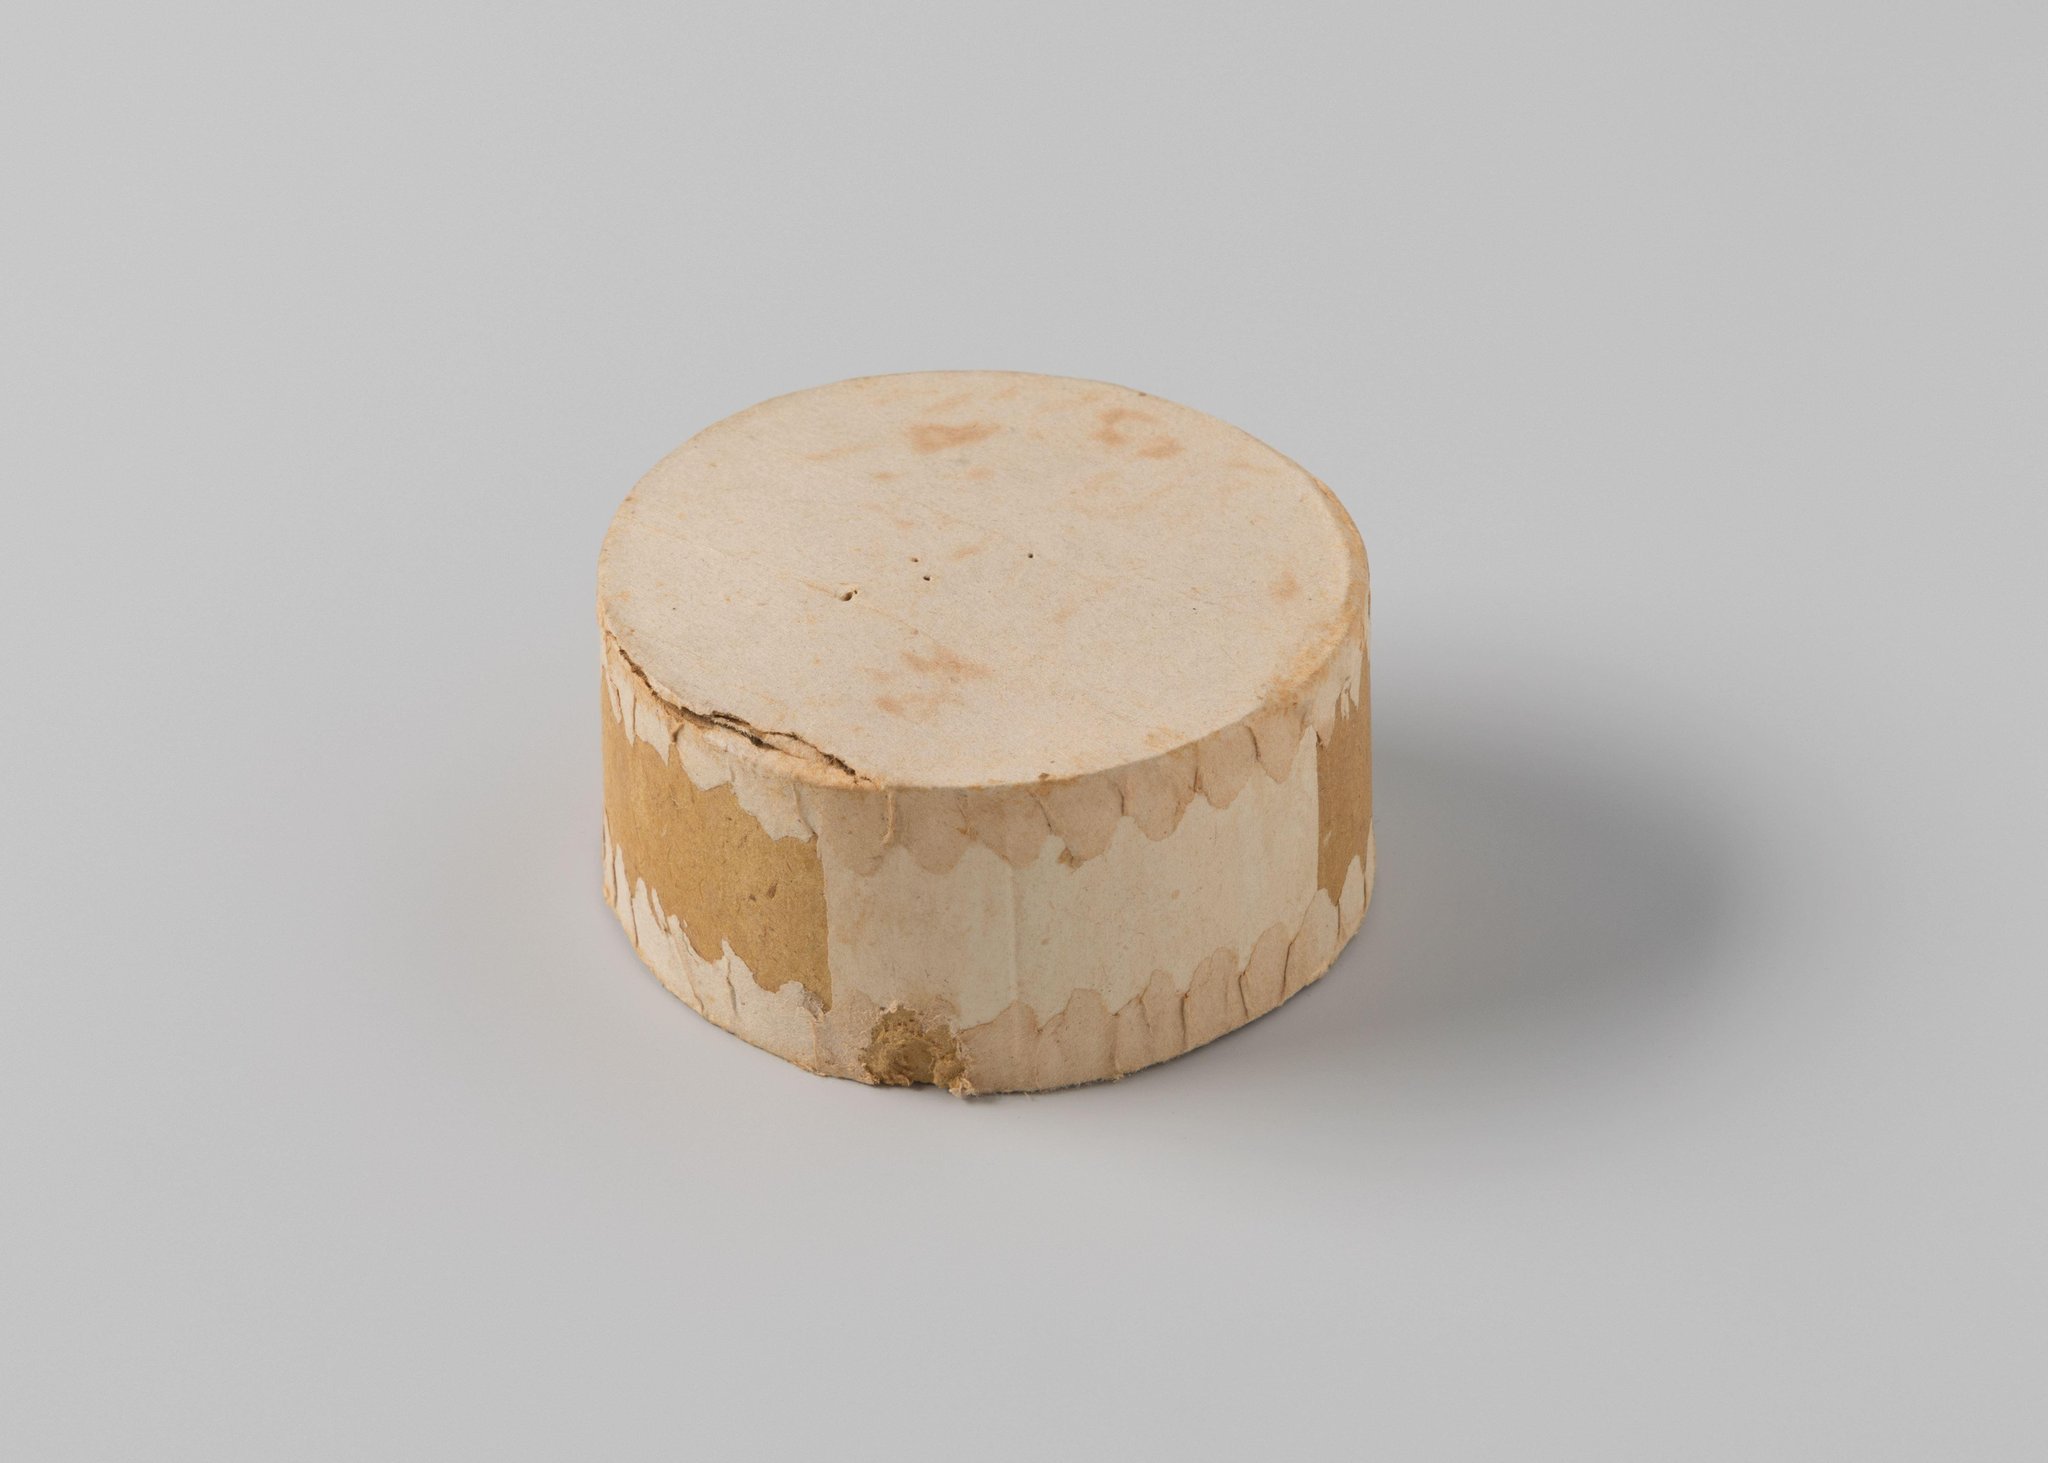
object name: packing material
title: Bewaardoos voor een rol lint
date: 1925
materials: cardboard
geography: france